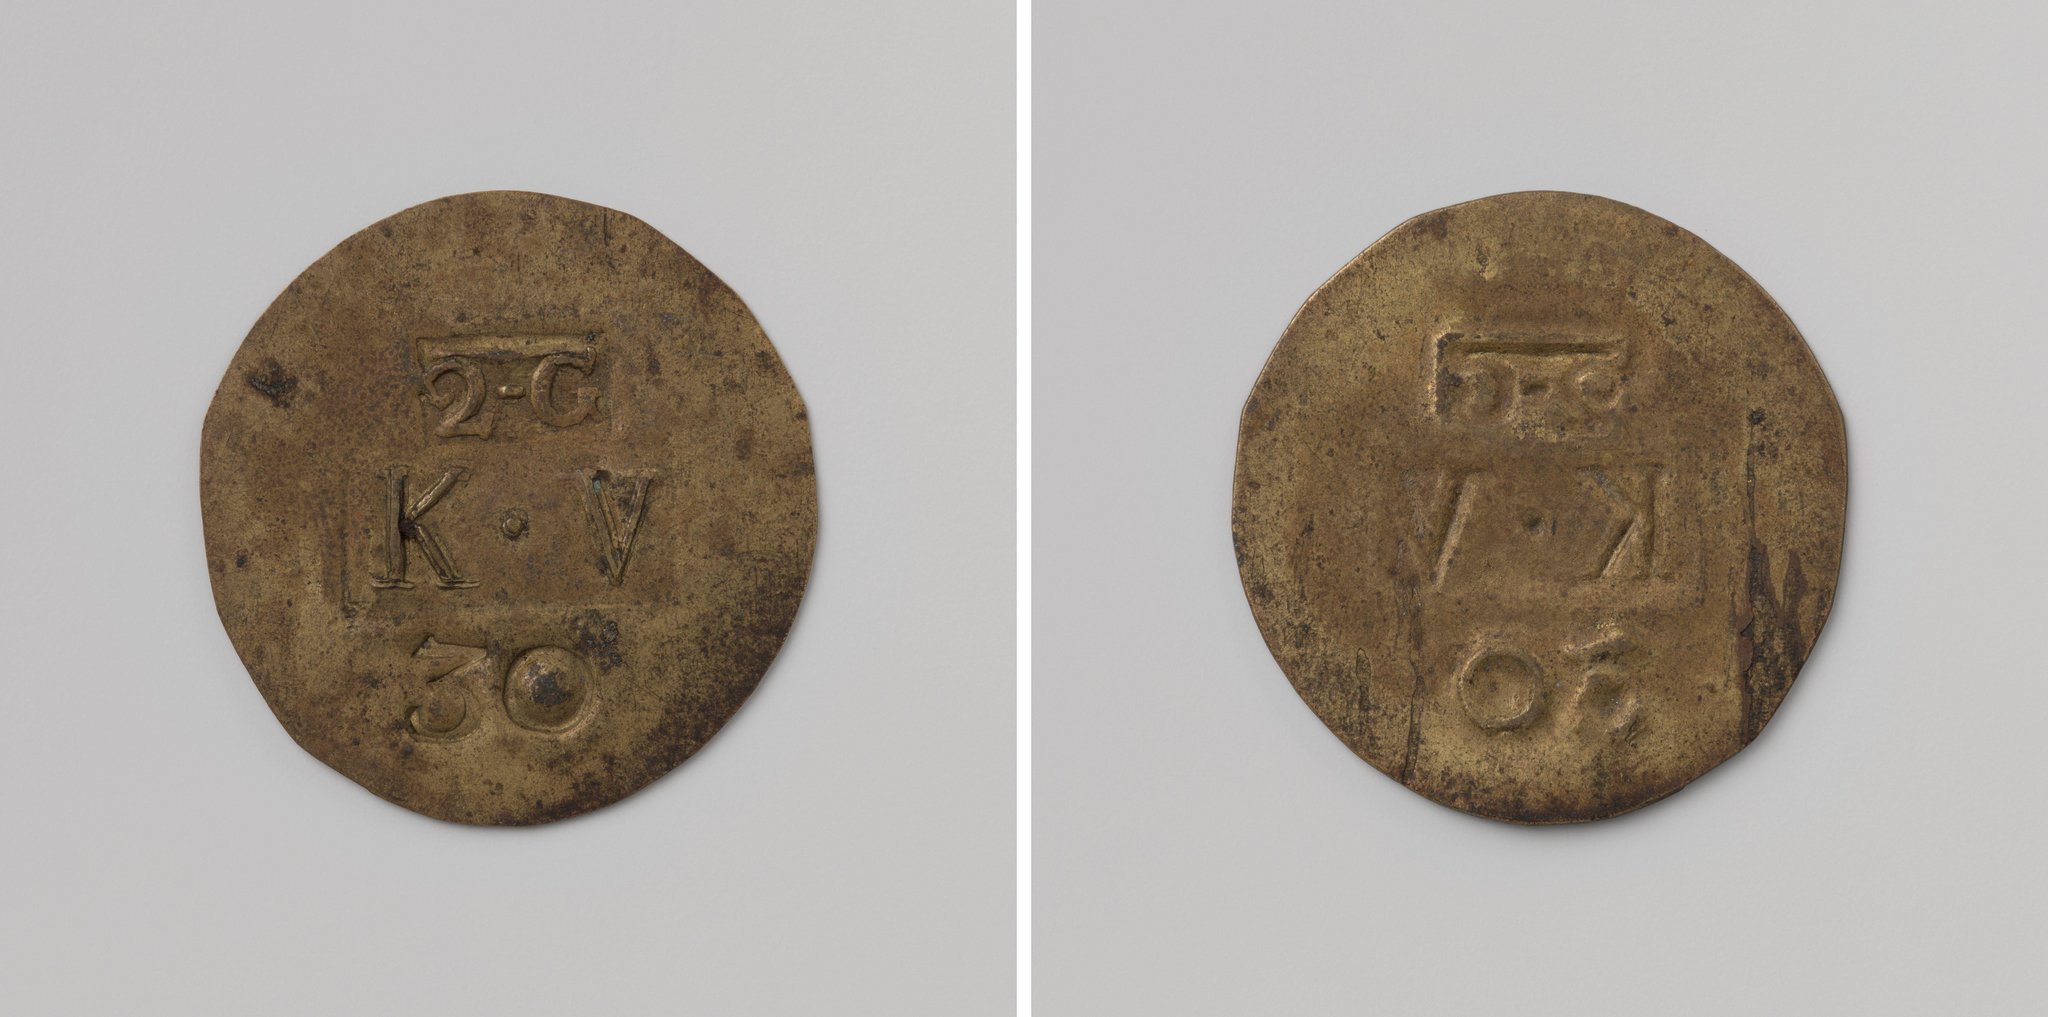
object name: monetary token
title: Tweede gesticht van de kolonie Veenhuizen, huismunt geslagen op last van de Maatschappij van Weldadigheid ter waarde van dertig cent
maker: Anonymous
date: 1818-1859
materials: brass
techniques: striking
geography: netherlands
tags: maatschappij van weldadigheid, veenhuizen